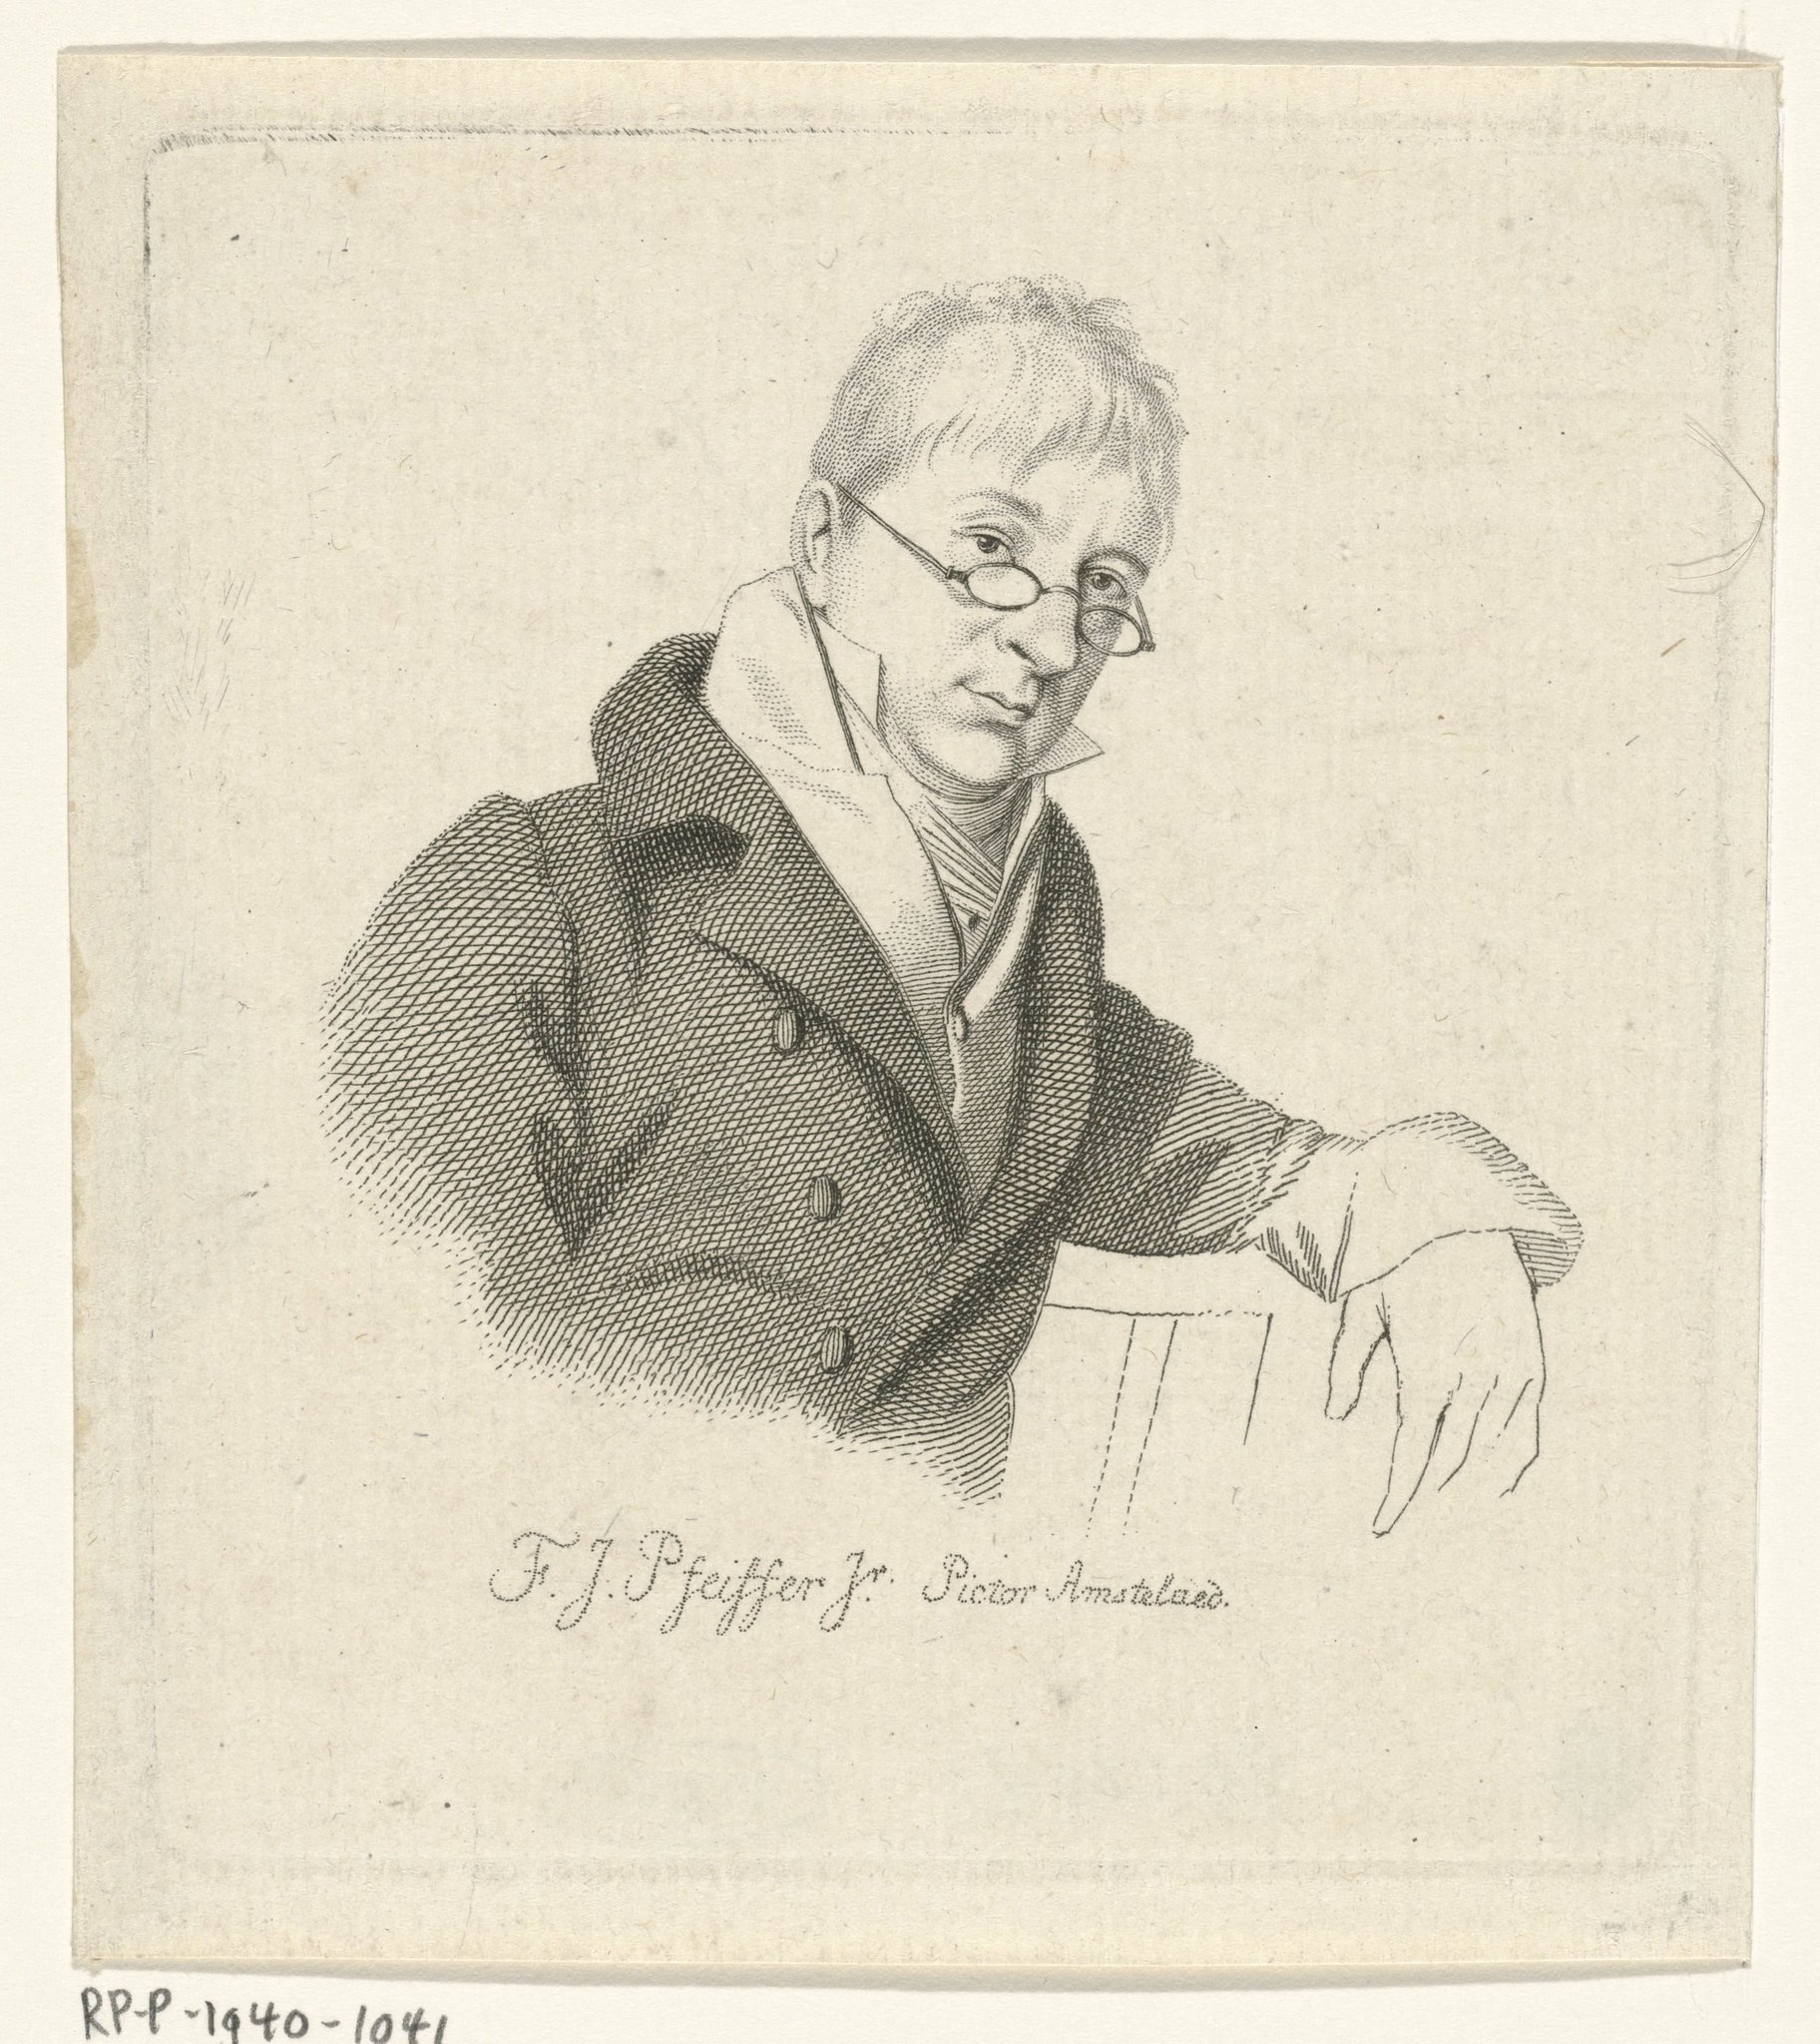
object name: print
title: Portret van François Joseph Pfeiffer II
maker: jacob ernst marcus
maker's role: draughtsman, print maker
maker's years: 1774-1826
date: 1815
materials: paper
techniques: etching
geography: amsterdam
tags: liège, print maker, draughtsman, françois joseph pfeiffer (ii), historical persons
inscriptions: collector's mark: Lugt 2228, collector's mark: Lugt 2760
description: Gehele prent gebruikt in: Jacob Ernst Marcus, Etudes gravées. Amsterdam: S. de Grebber, 1826.